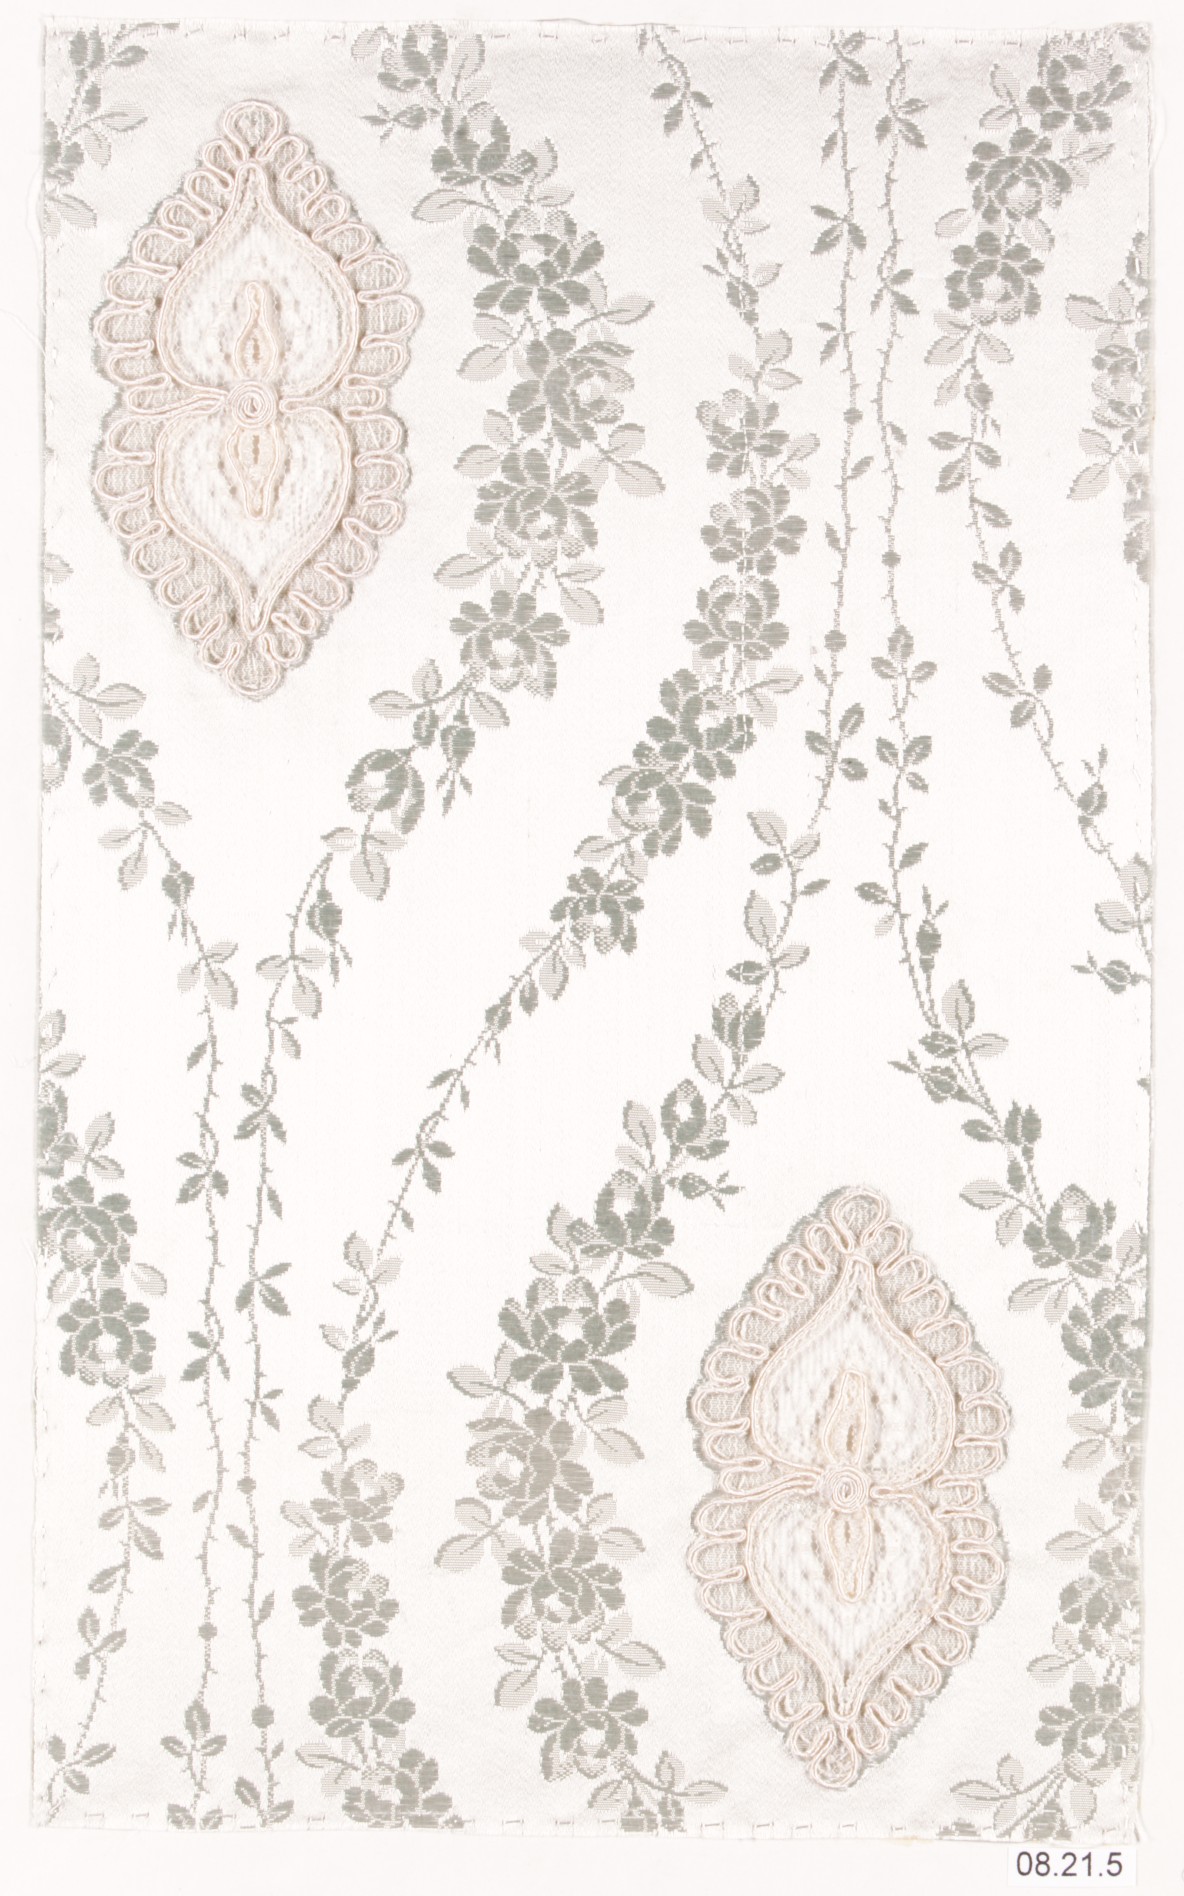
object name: textile sample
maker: Anonymous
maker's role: designer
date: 1900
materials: silk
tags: flowers